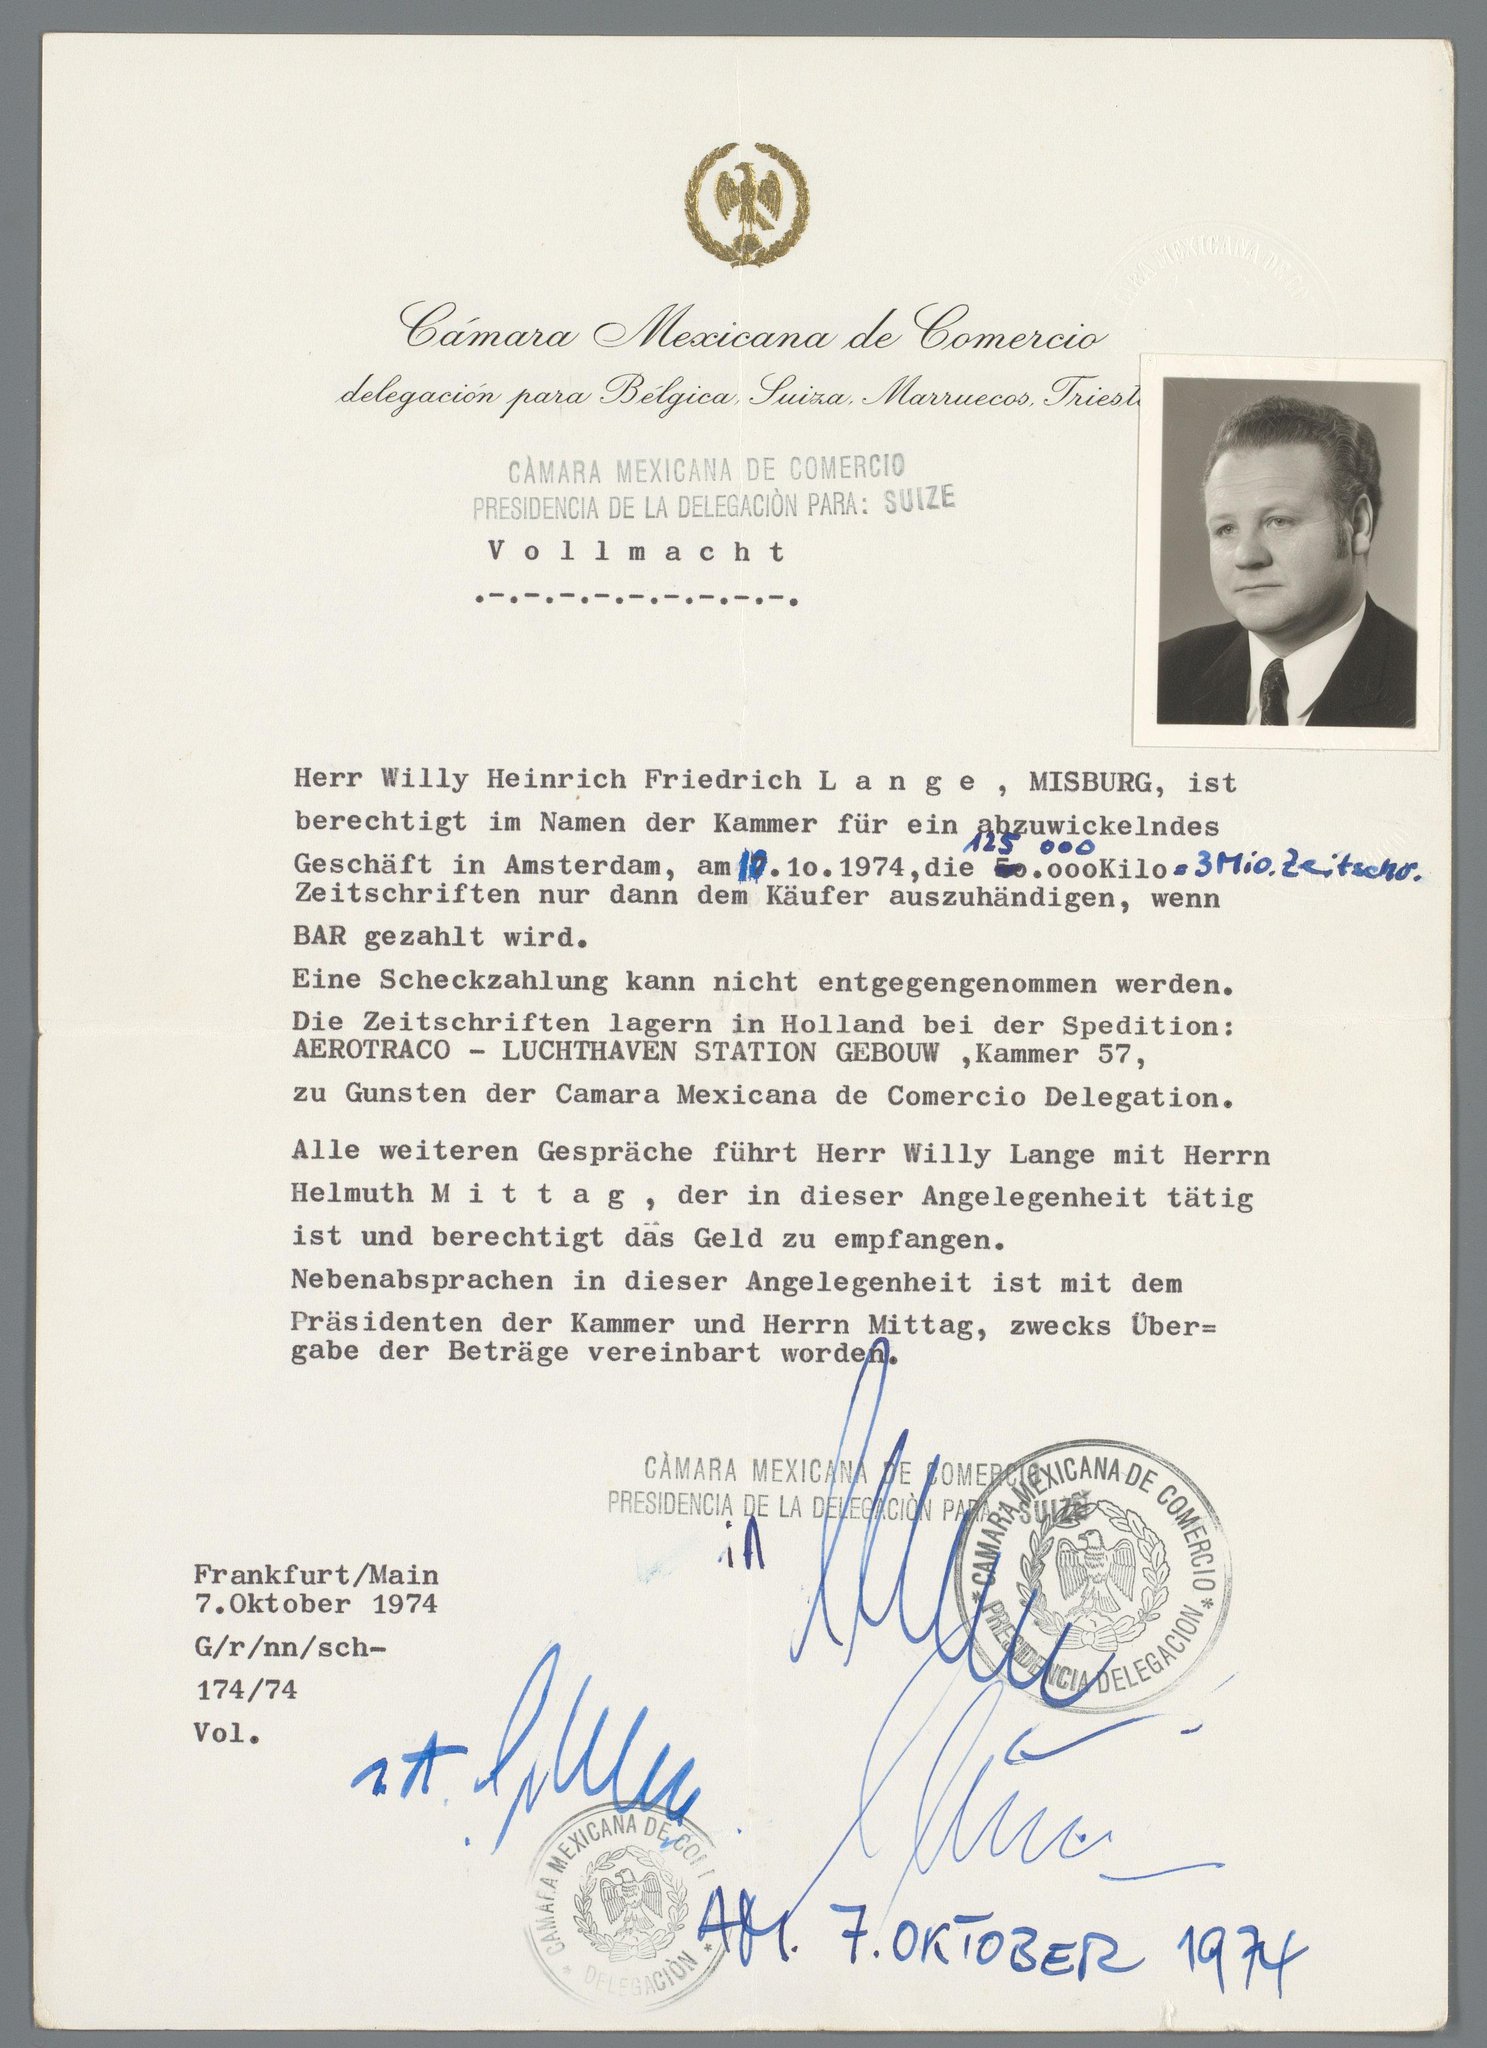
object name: document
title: Vollmacht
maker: Anonymous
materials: paper, ink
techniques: gelatin silver print, letterpress printing, pen, typewriting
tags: export, historical persons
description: Blijkens een handgeschreven notitie van L.J. Hartkamp zou het hier zijn gegaan om een partij van drie miljoen pornografische tijdschriften.